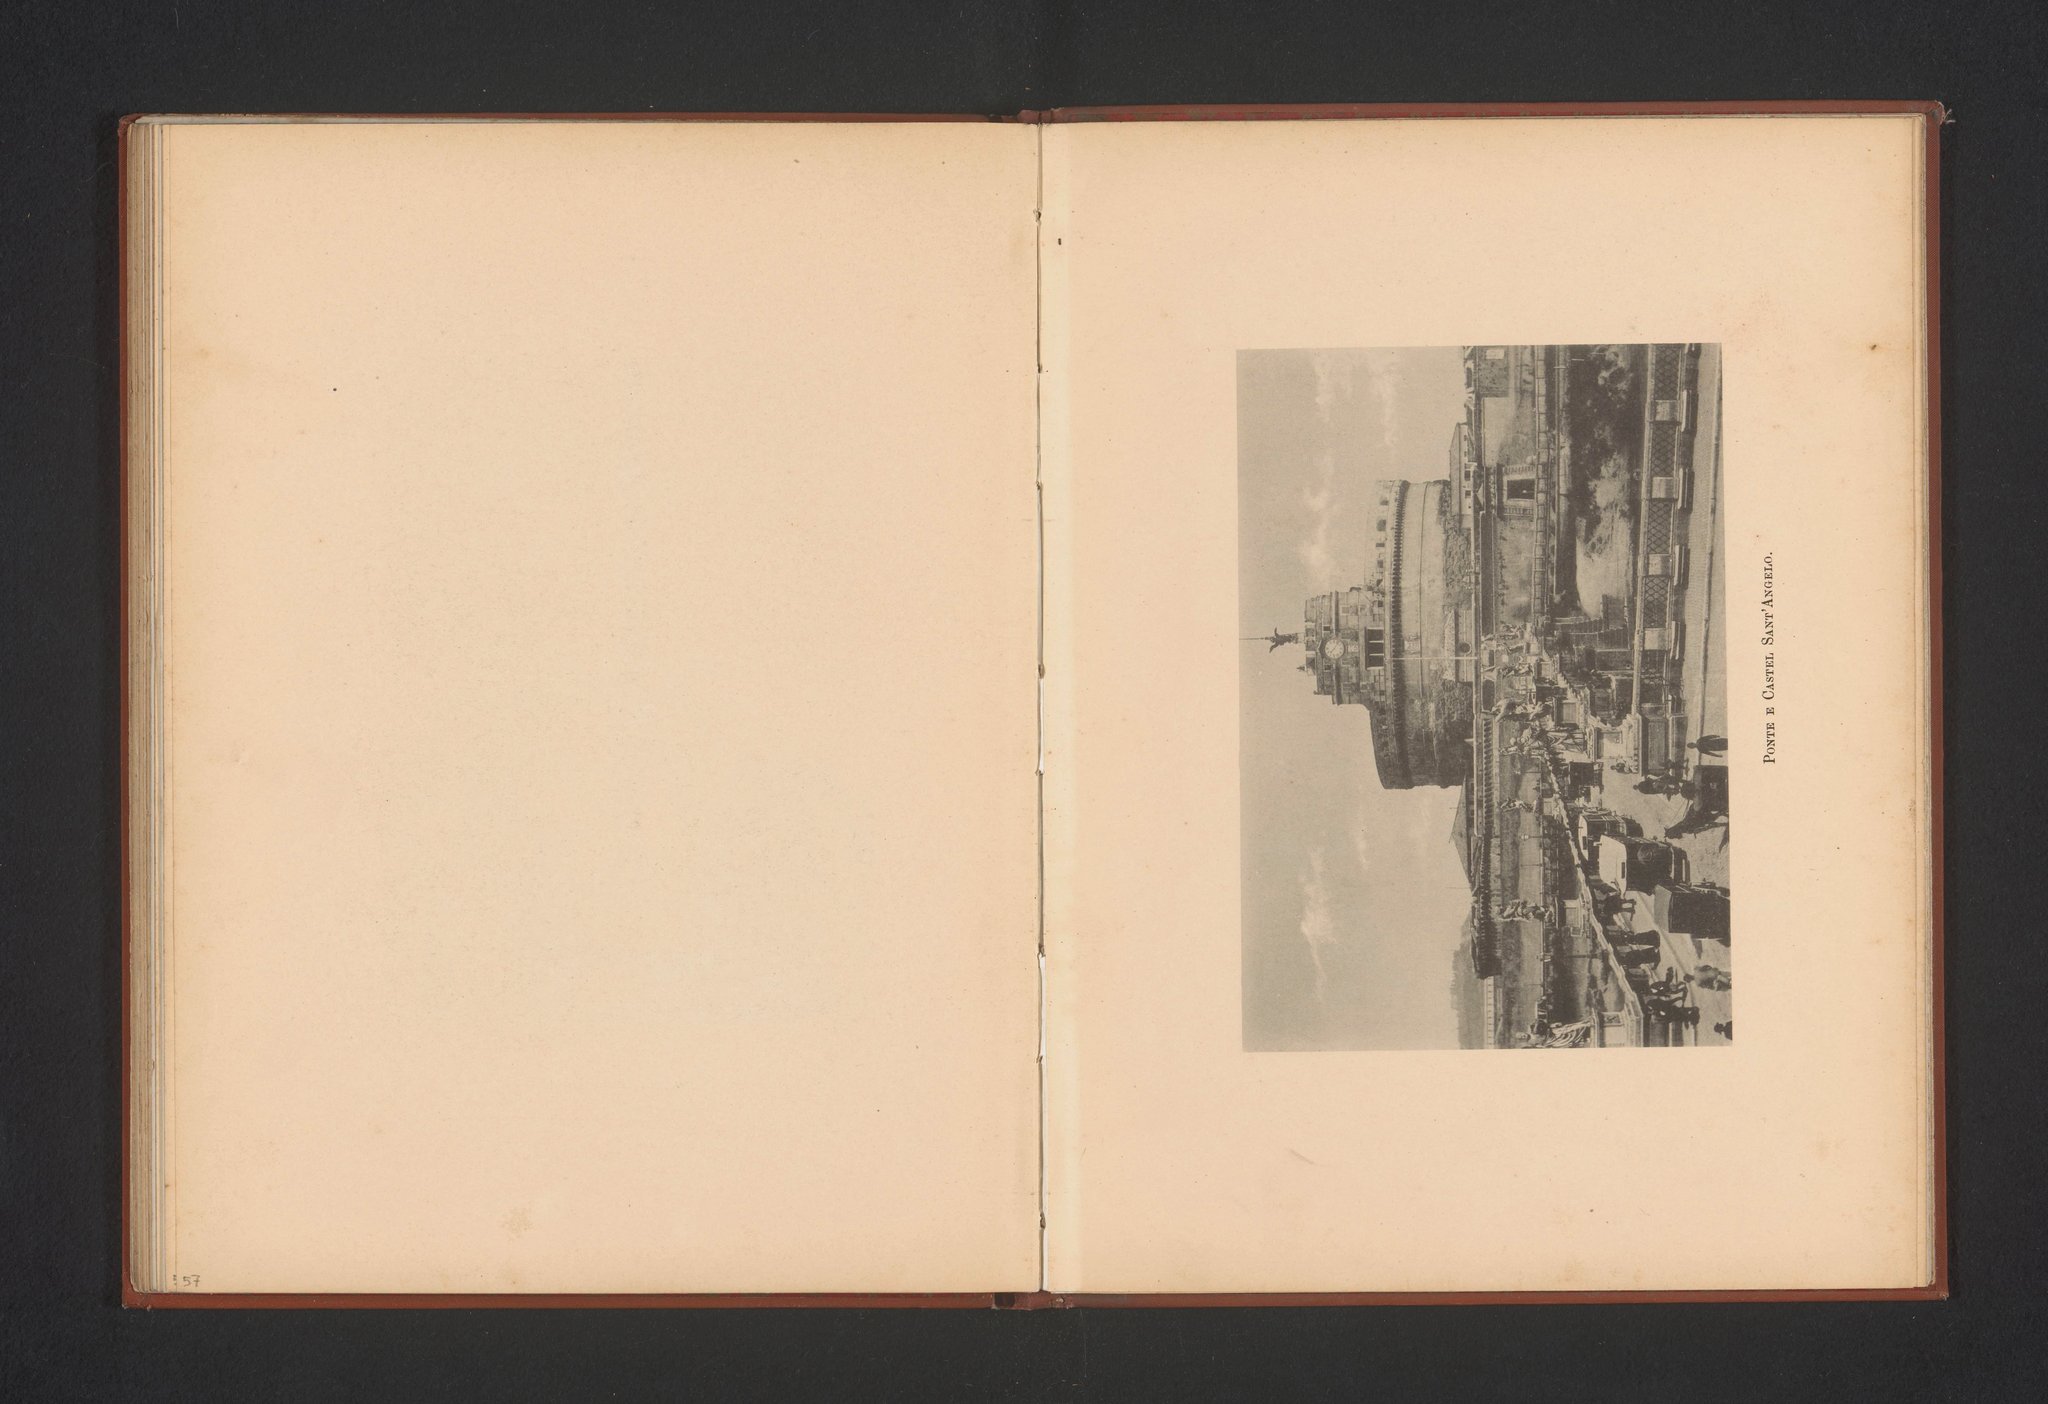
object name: photomechanical print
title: Ponte e Castel Sant'Agelo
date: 1893-1898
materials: paper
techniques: photograph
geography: rome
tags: castle, bridge